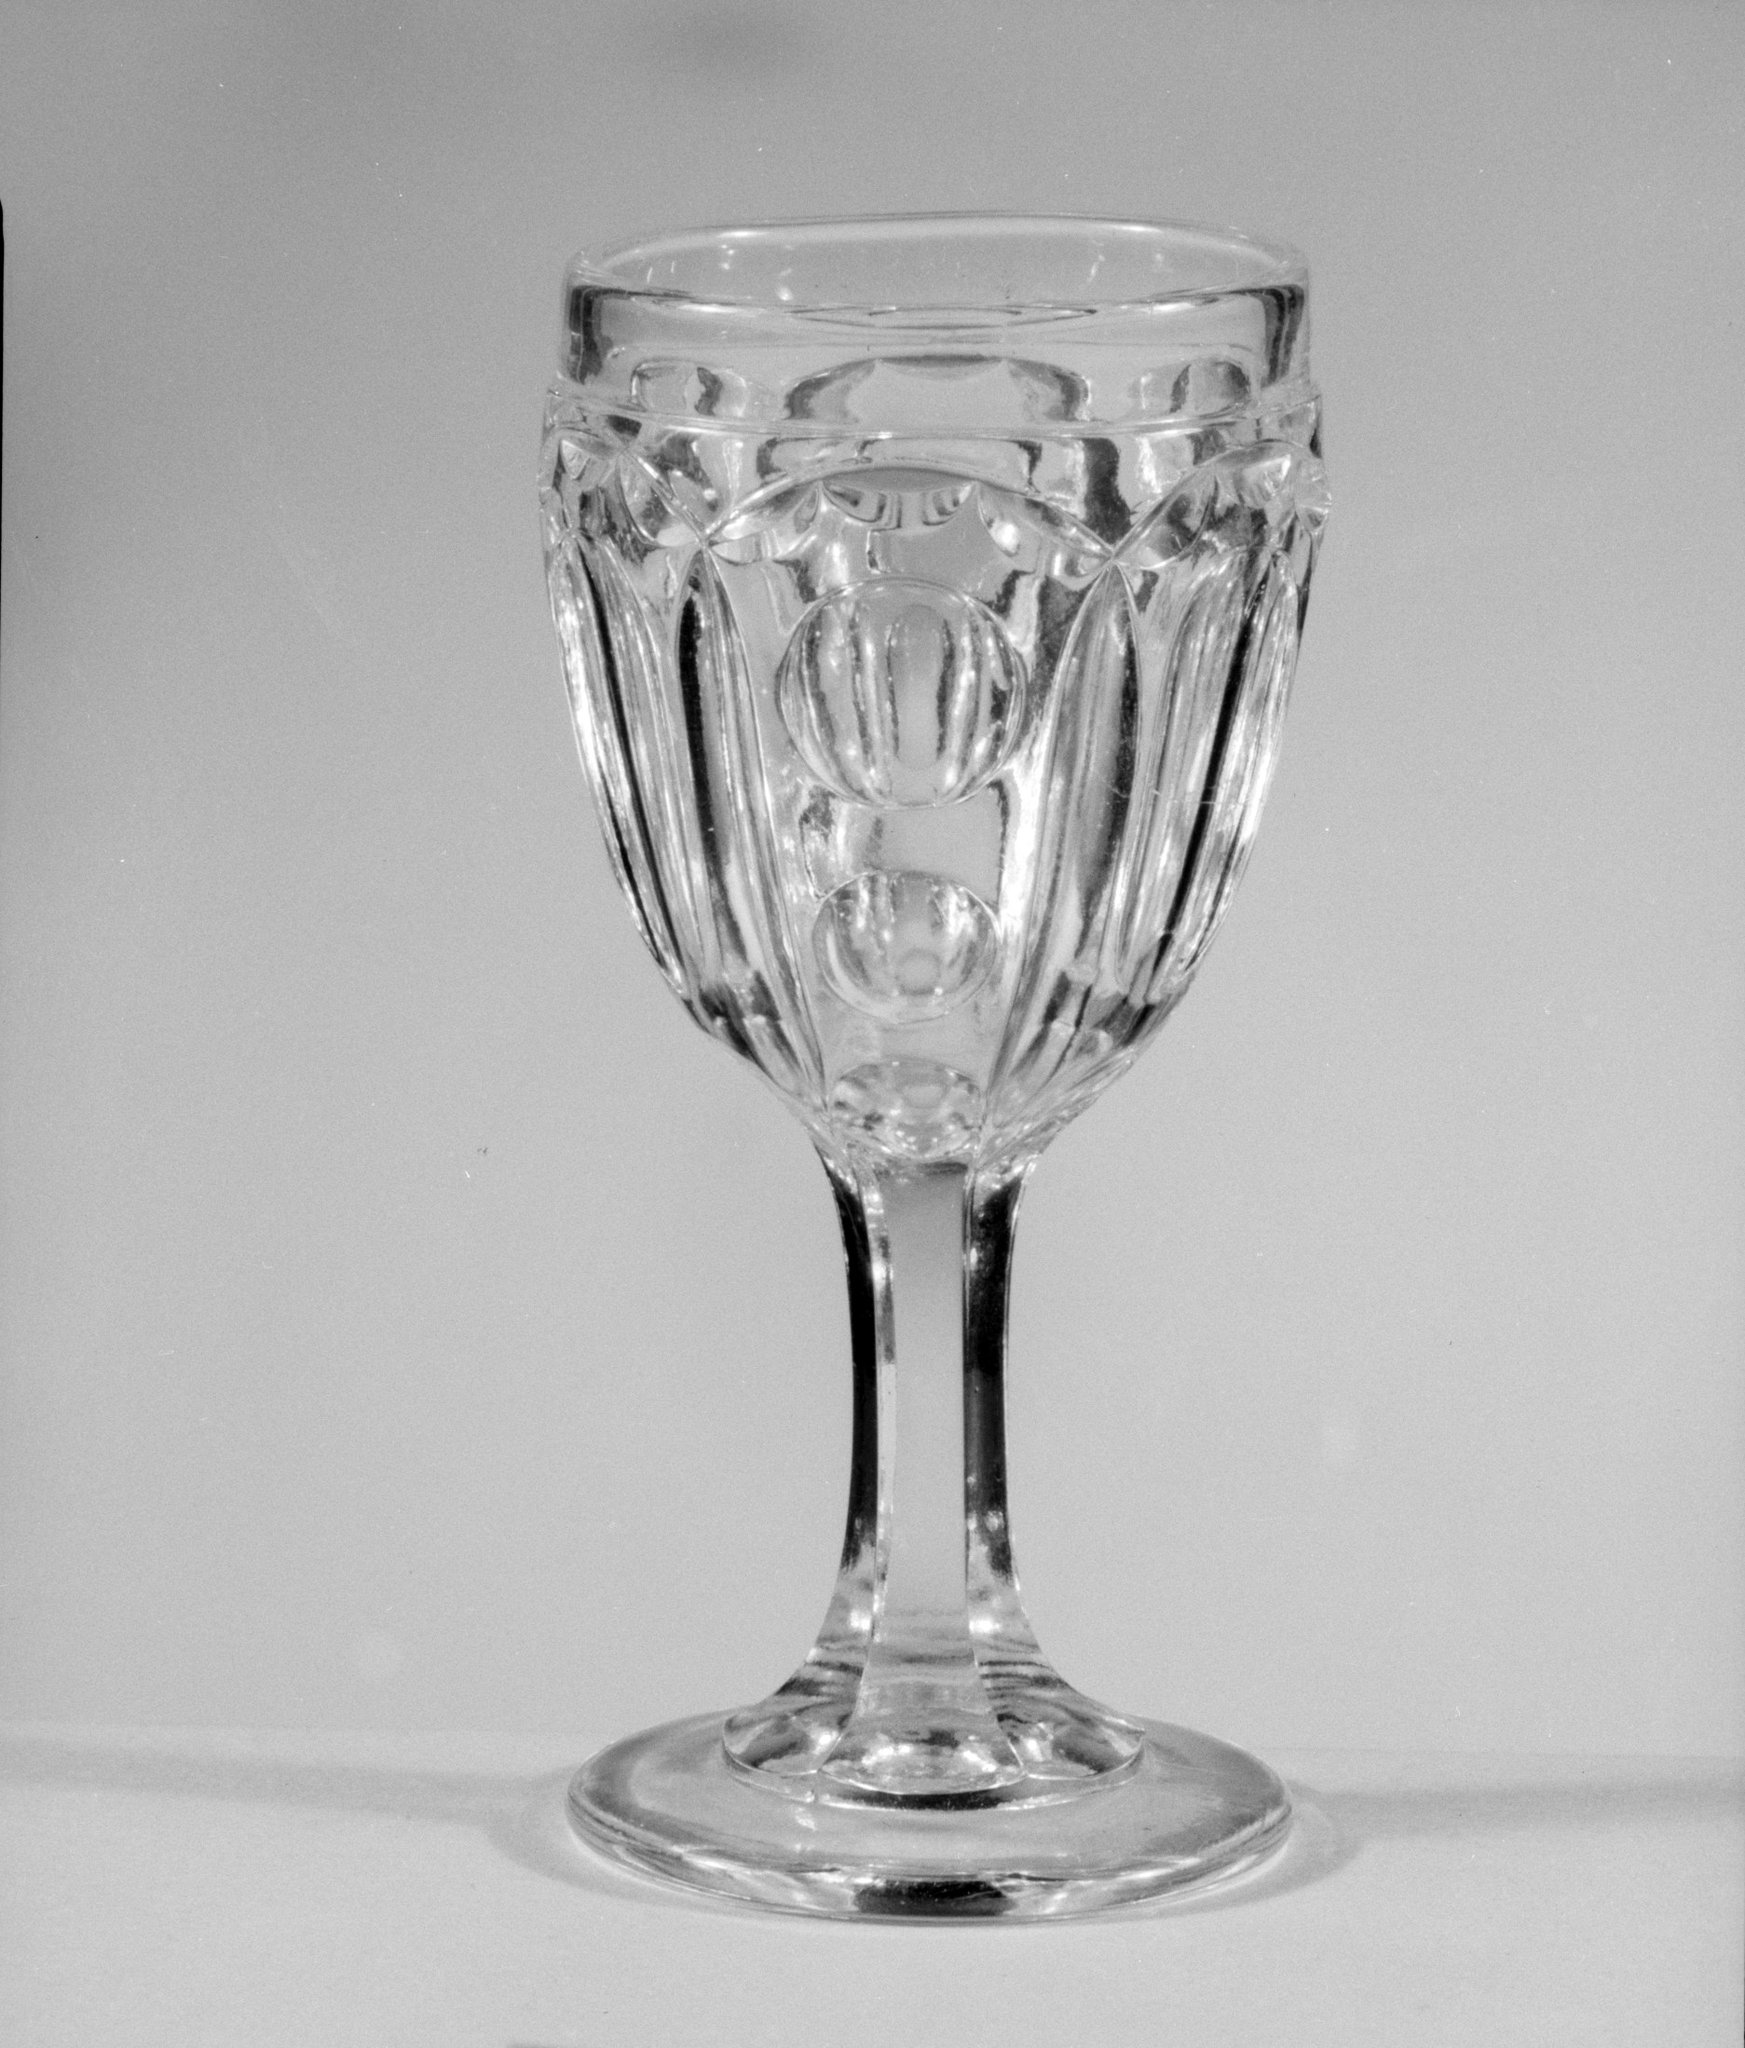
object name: cordial glass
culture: american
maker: new england glass company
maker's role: maker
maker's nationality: american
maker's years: 1818-1888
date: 1865-1870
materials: glass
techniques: pressed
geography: united states